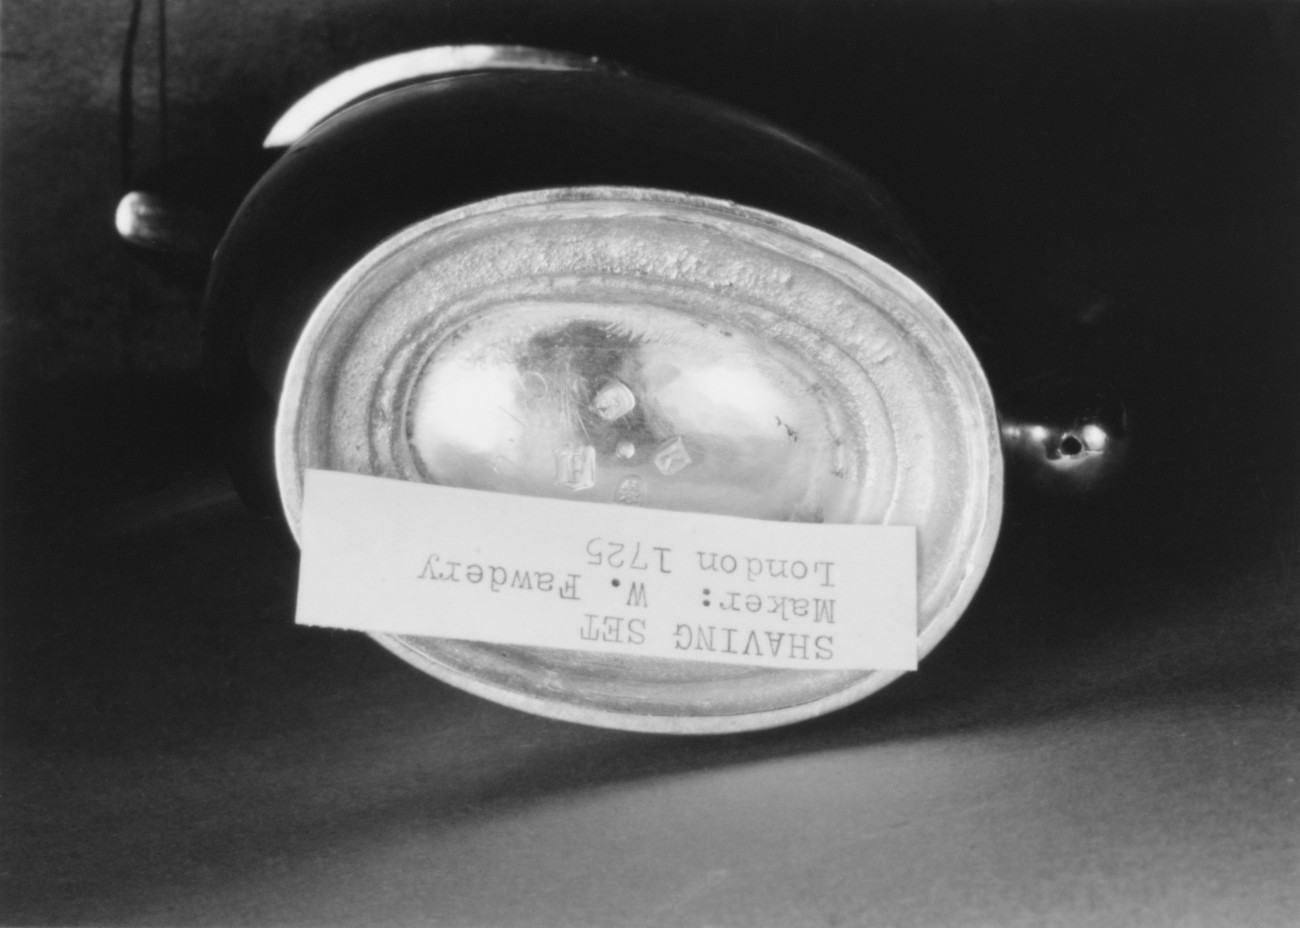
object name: shaving dish and jug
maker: william fawdery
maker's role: maker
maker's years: 1698-1727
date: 1725-1726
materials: silver